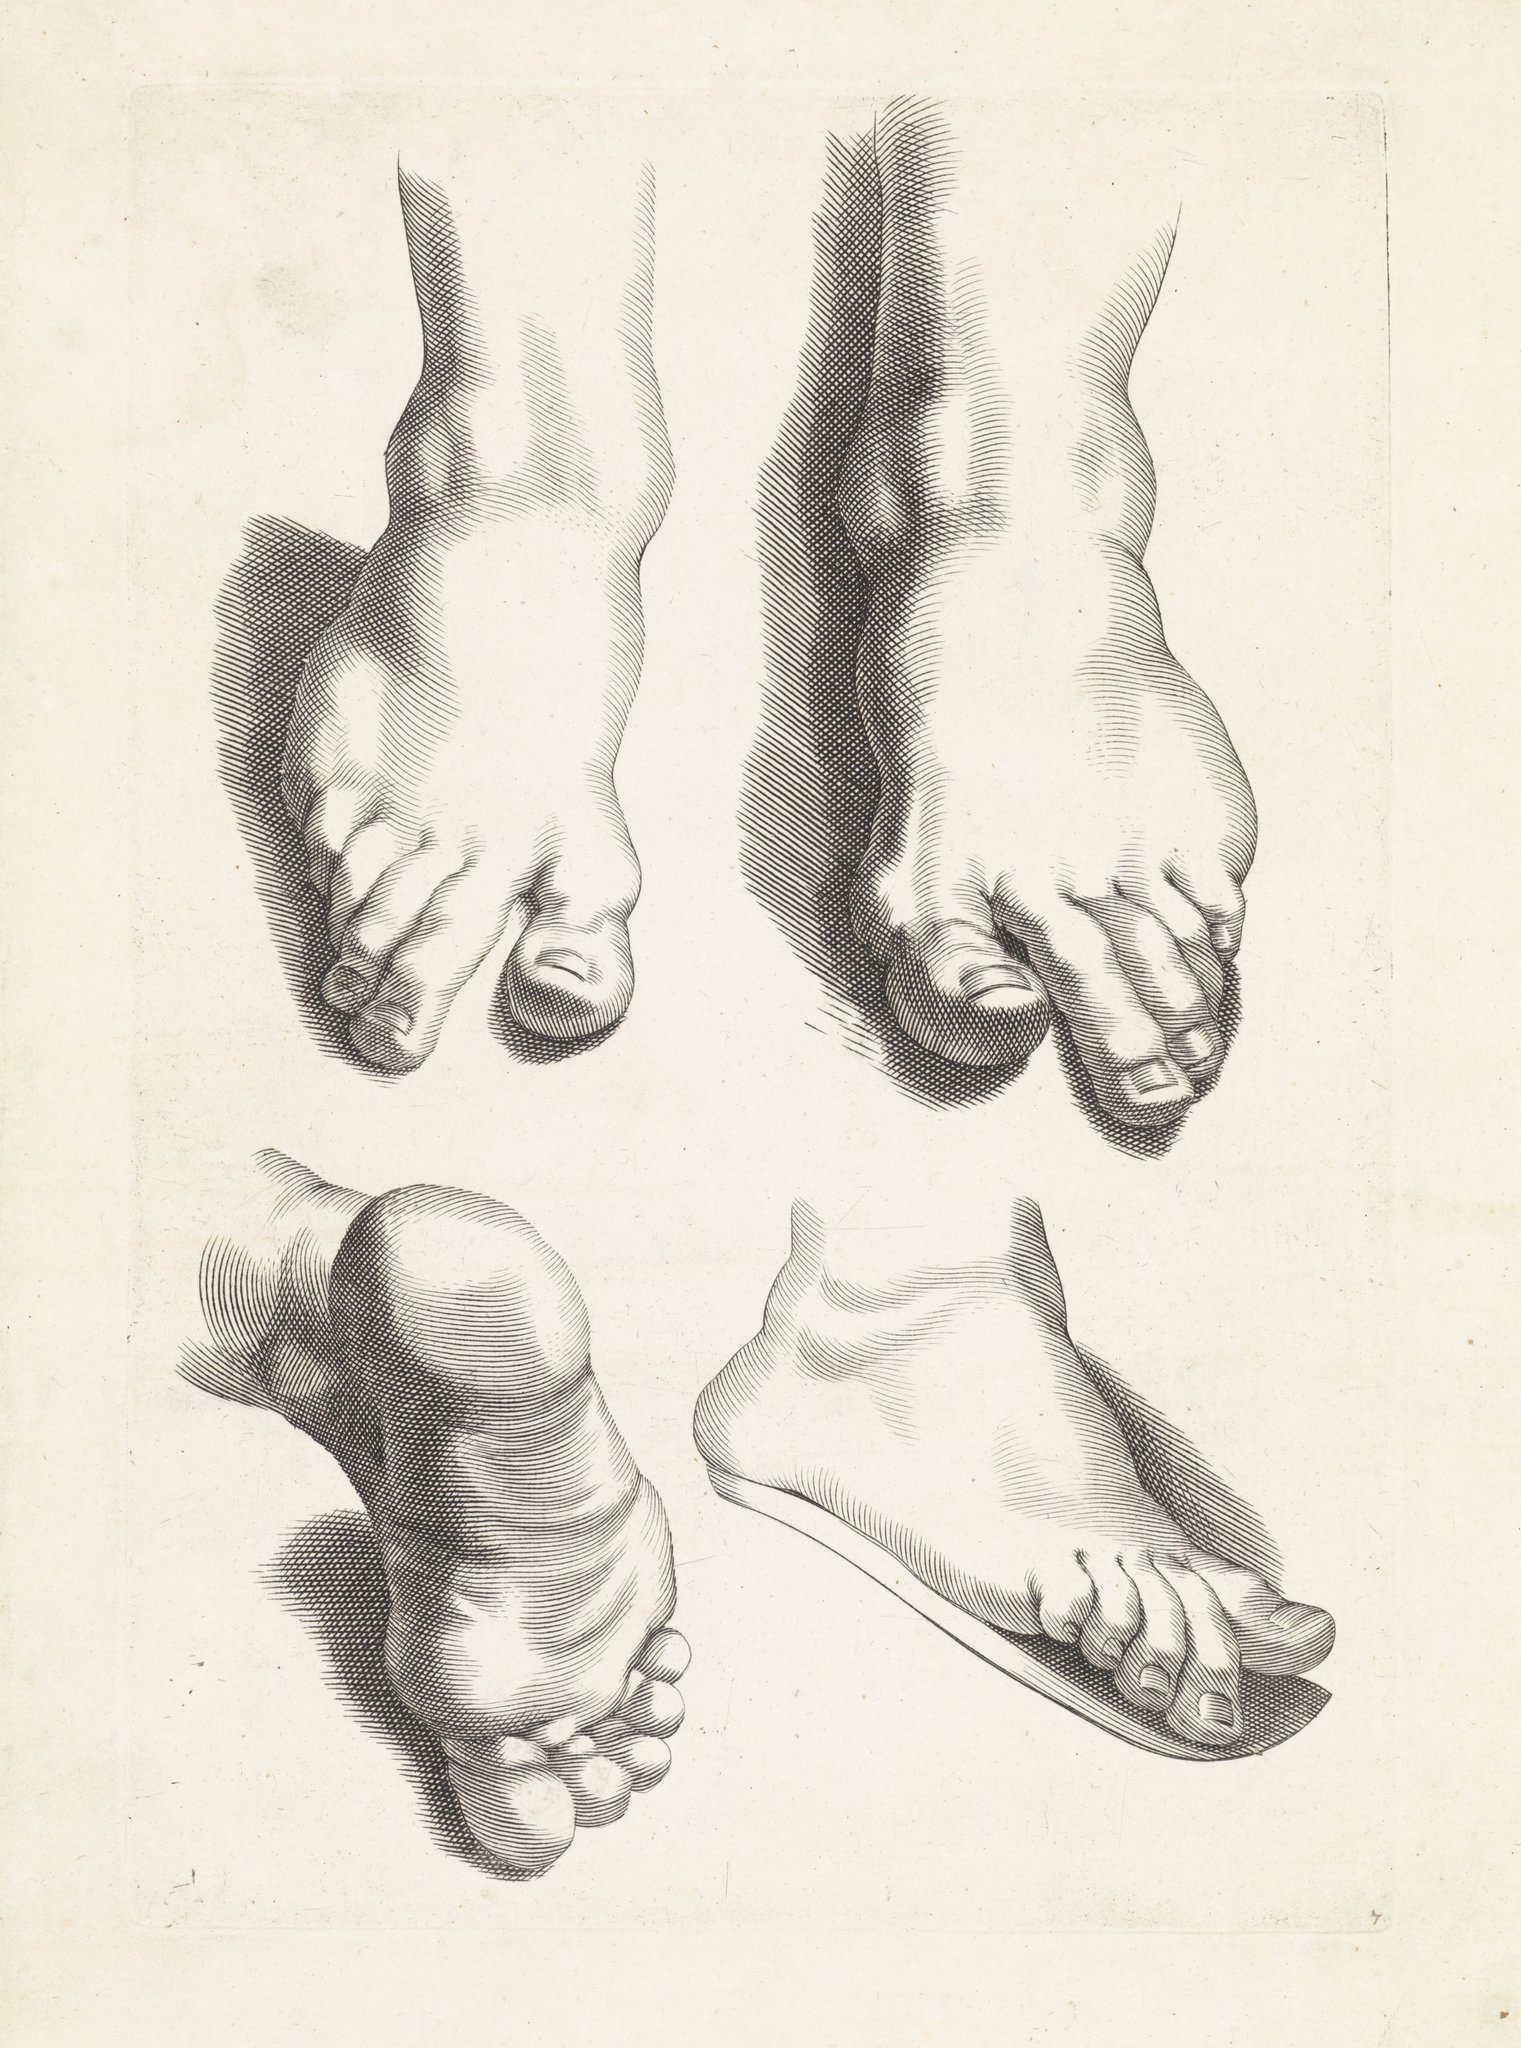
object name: print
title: Het tekenboek van Peter Paul Rubens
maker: paulus pontius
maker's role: draughtsman, print maker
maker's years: 1603-1658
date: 1616-1657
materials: paper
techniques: engraving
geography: antwerp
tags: foot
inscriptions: number: ‘4’, collector's mark: Lugt 240